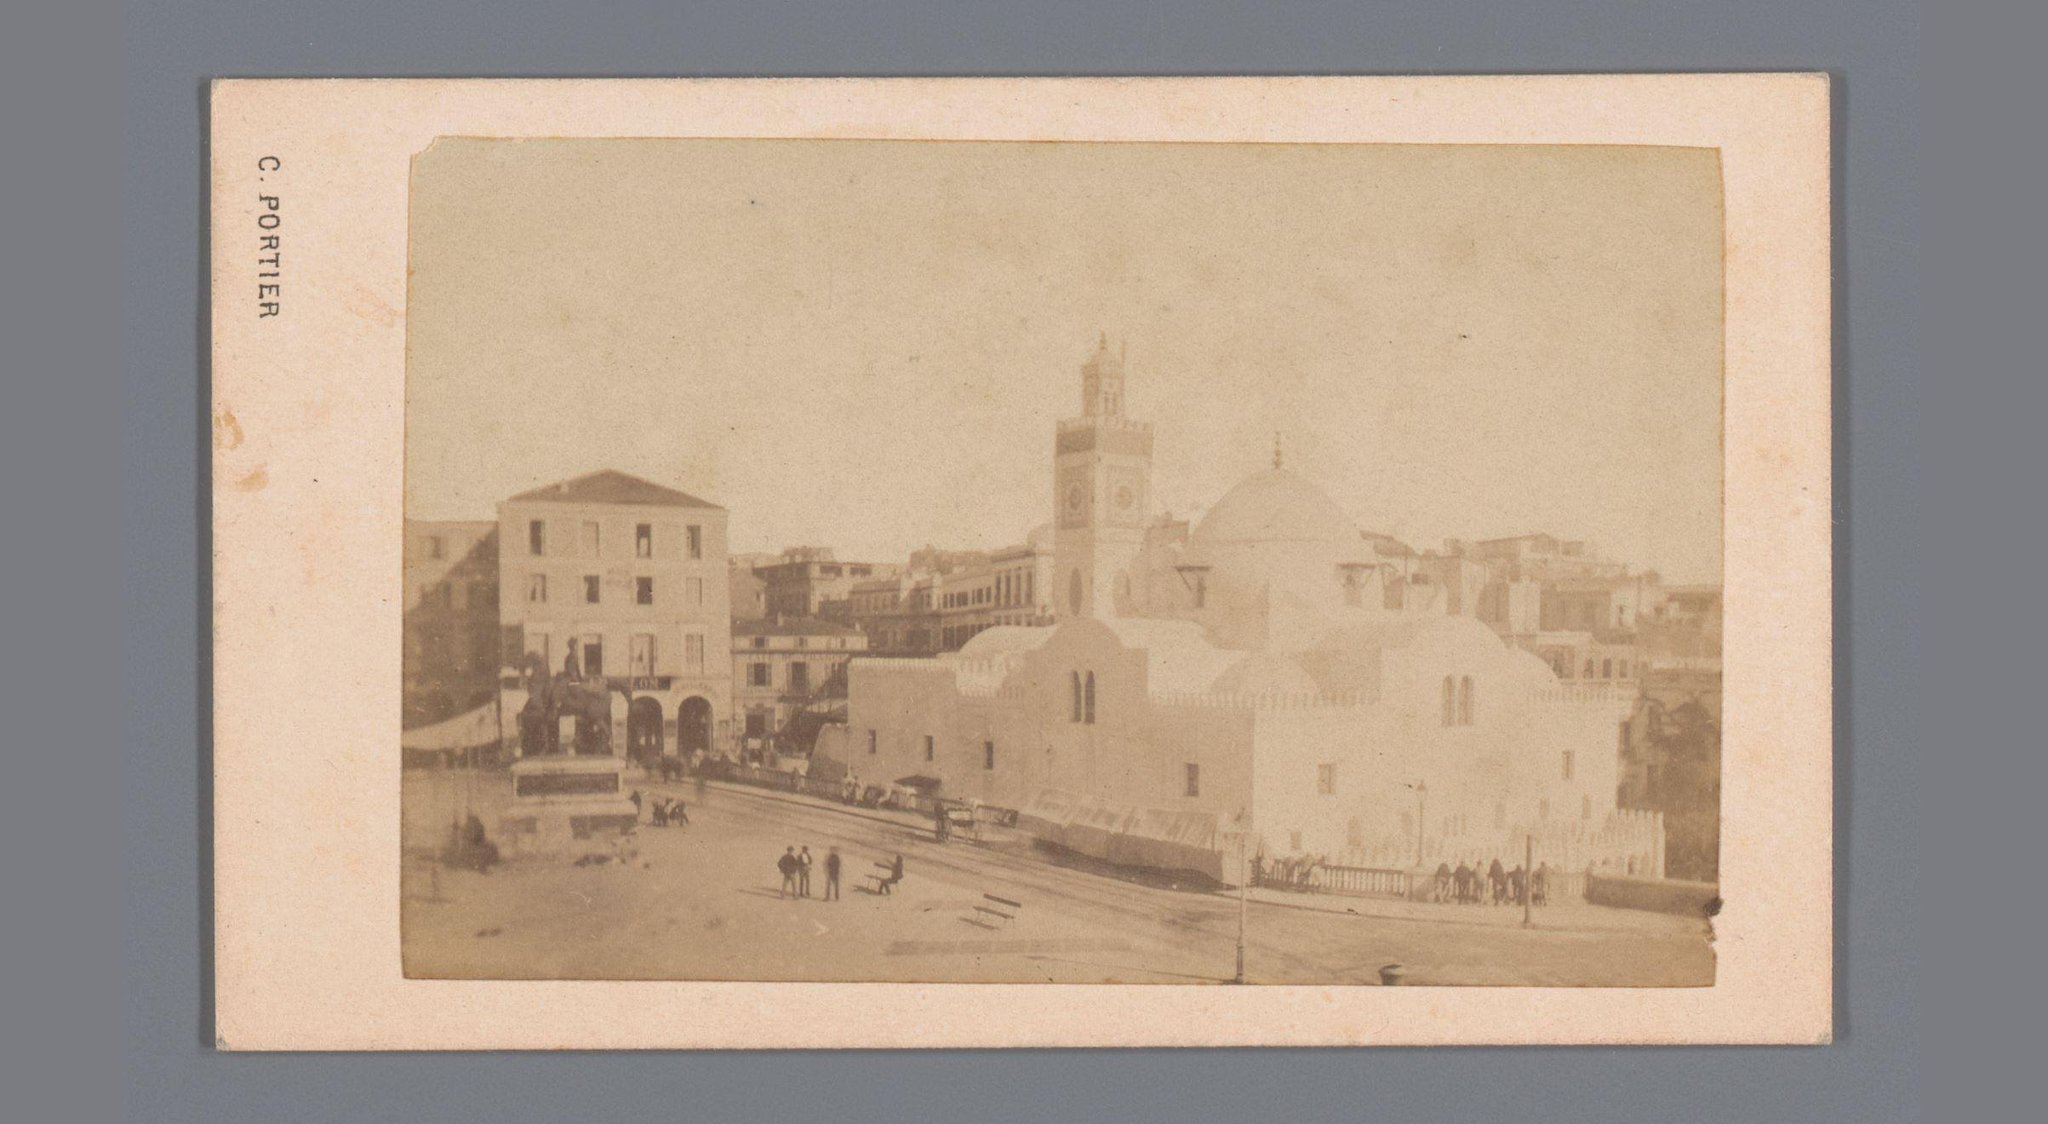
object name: photograph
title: Place du Gouvernement en de Djama'a al-Djedid, Algiers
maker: claude-joseph portier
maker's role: fotograaf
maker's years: 1841-1910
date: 1863-1882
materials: cardboard, paper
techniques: albumen print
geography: algiers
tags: square, place, circus, etc., temple, shrine ~ islam, mohammedanism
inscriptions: inscription: ‘C. Portier/ Photographe Paysagiste/ Alger/ Vues et types de toute l'Algérie/ Magasin de vente/ Rue bab-Azoun,/ (au coin de la Rue de la Flèche)’, inscription: ‘C. Portier’